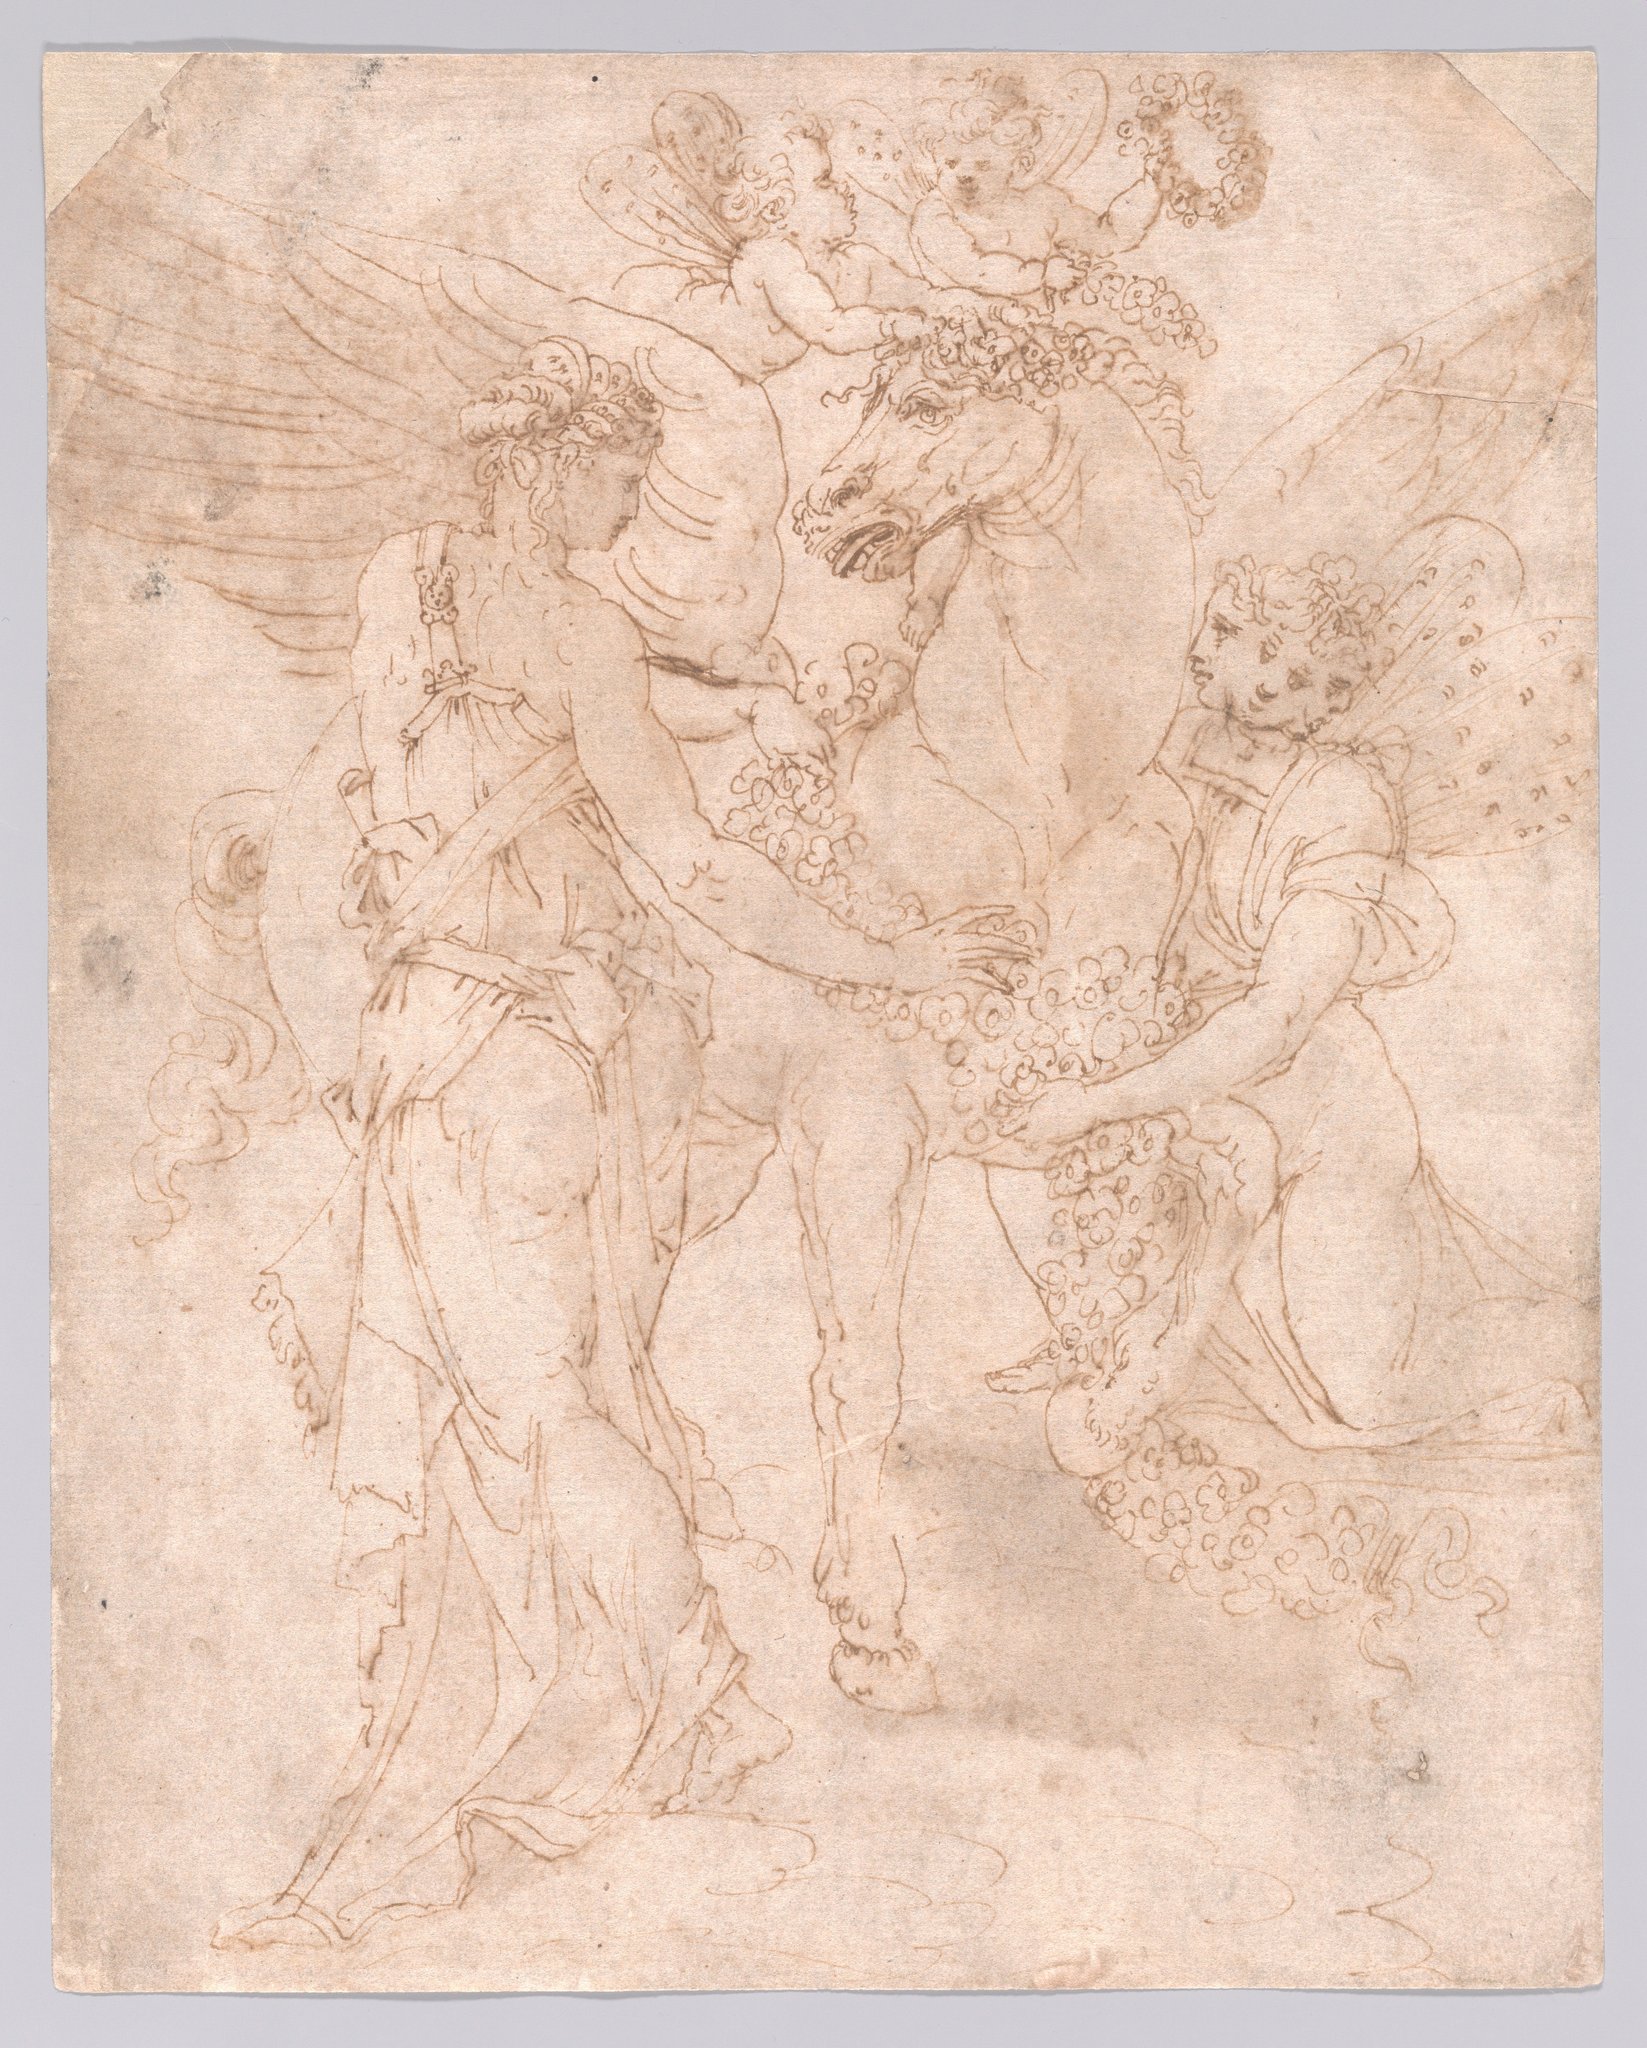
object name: drawing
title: Diana and Hecate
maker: rosso fiorentino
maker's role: artist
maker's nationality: italian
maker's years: 1494-1540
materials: ink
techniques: pen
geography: italy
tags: diana,horses